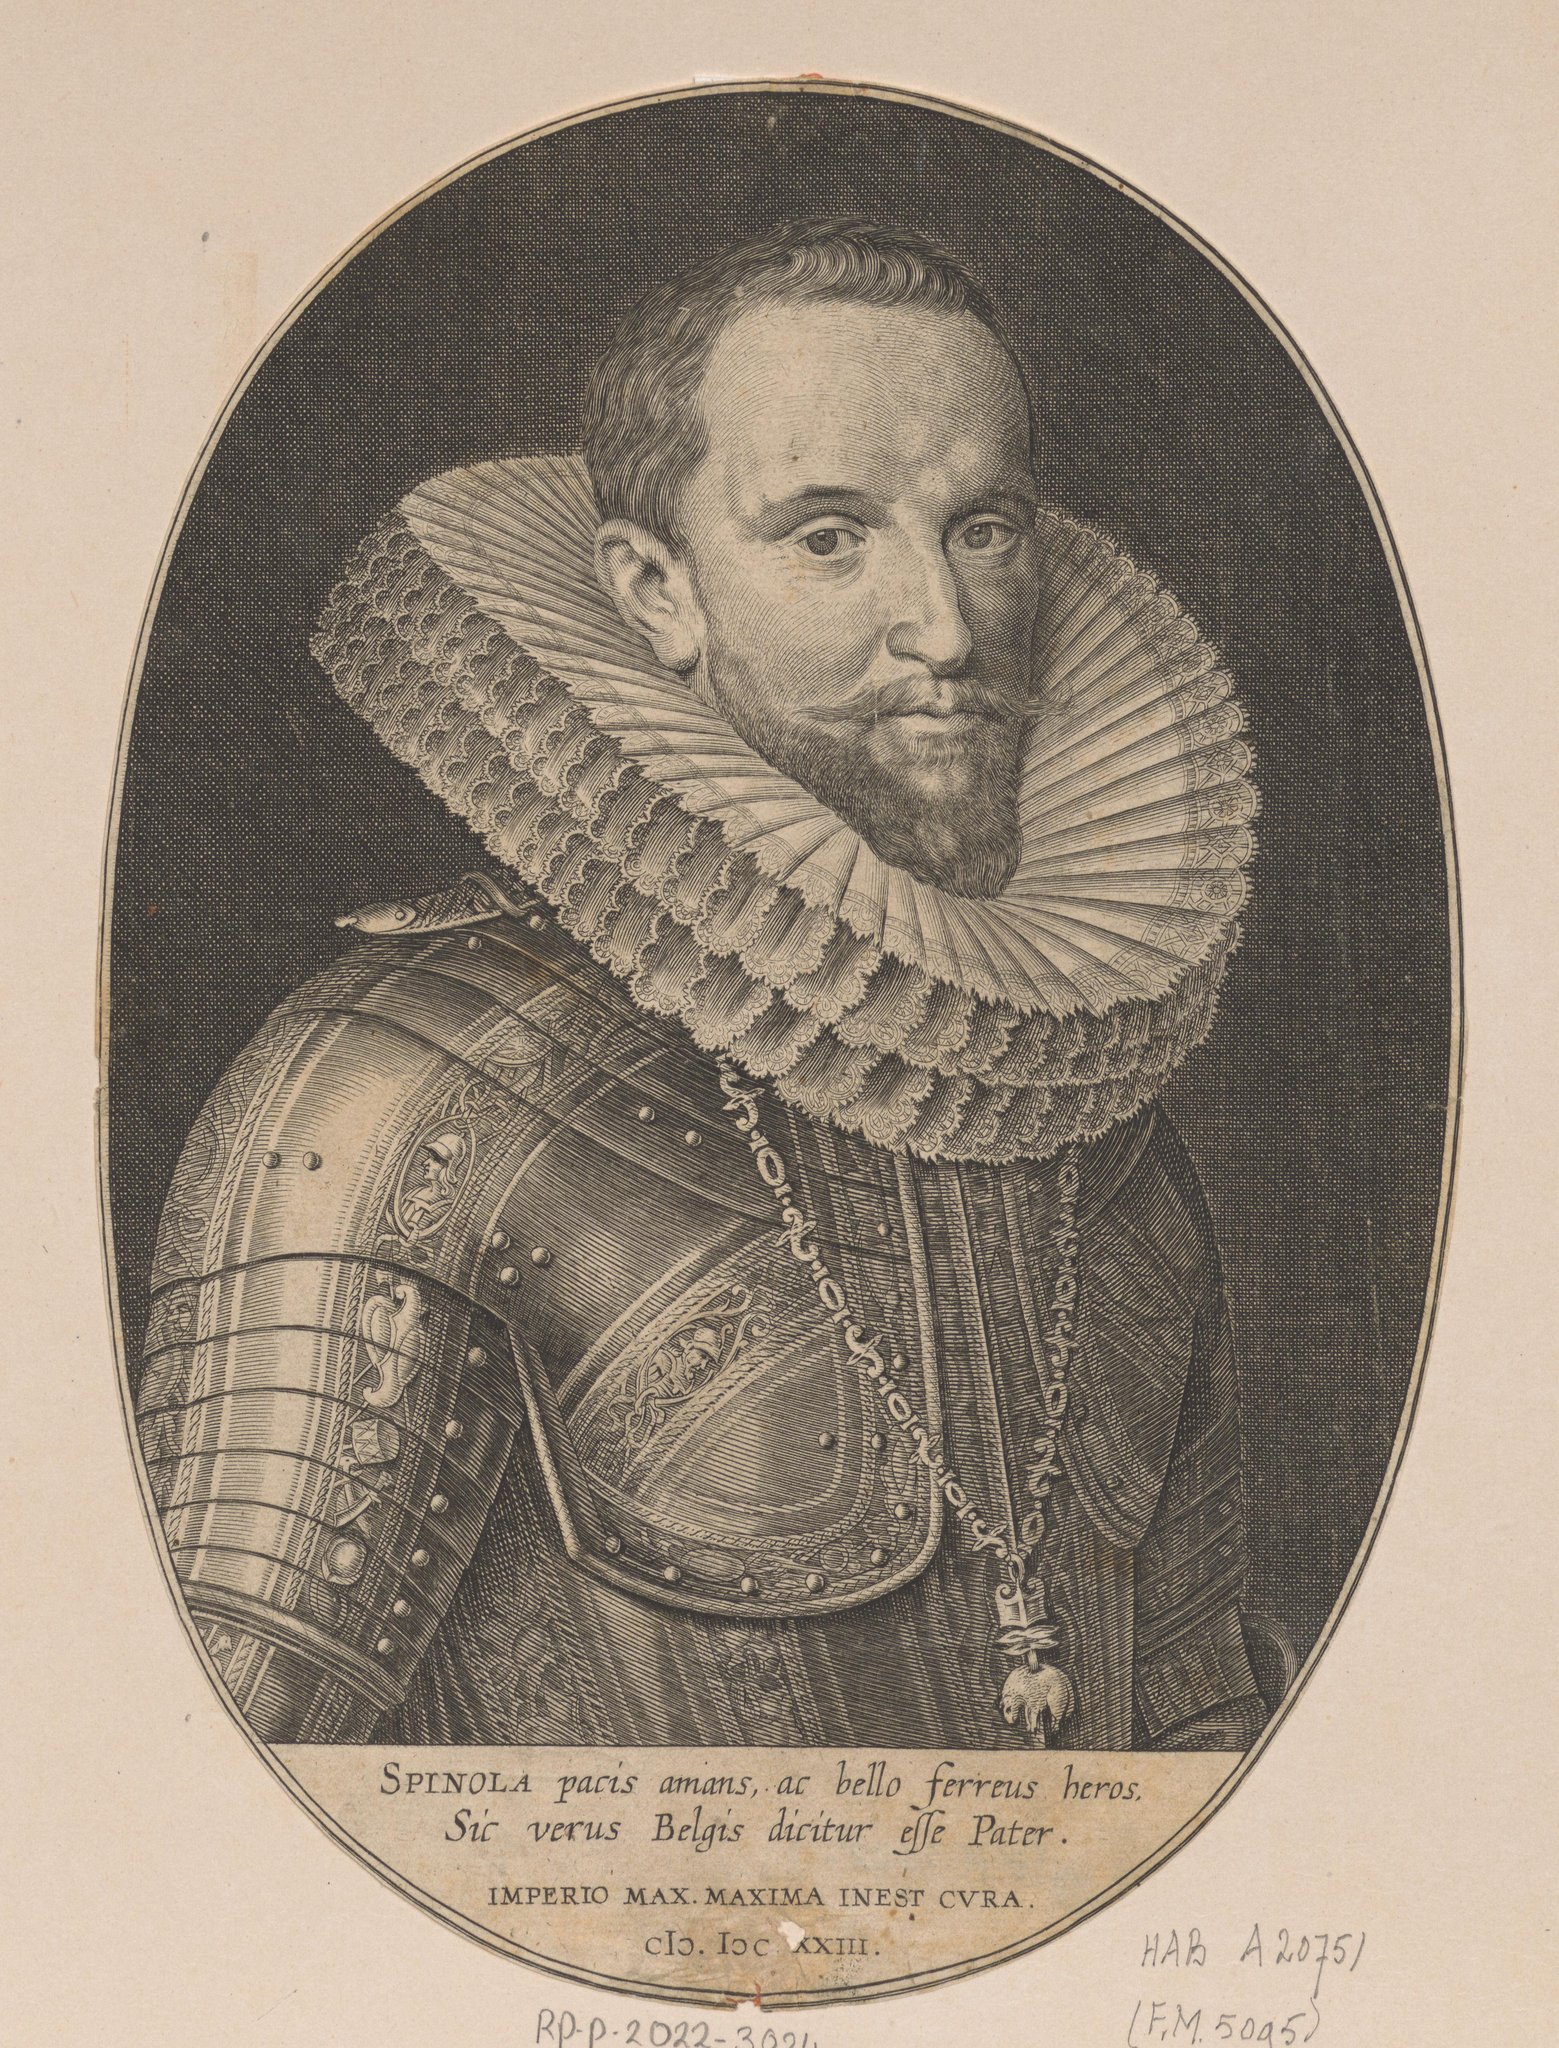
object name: print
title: Portret van Ambrogio Spinola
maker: pieter de jode (i)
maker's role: draughtsman, print maker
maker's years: 1570-1634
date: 1620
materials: paper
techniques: engraving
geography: antwerp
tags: commander-in-chief, general, marshal, historical persons, knighthood order of the golden fleece - insignia of a knighthood order, e.g.: badge, chain (with name of order)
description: Prent waarschijnlijk uit: Meerbeeck, Adriaen van, Willem de Haen en Pieter de Jode (II). Chroniicke vande gantsche vverelt, ende sonderlinghe vande seventhien Nederlanden (...). Antwerpen: Hieronymus Verdussen, 1620.